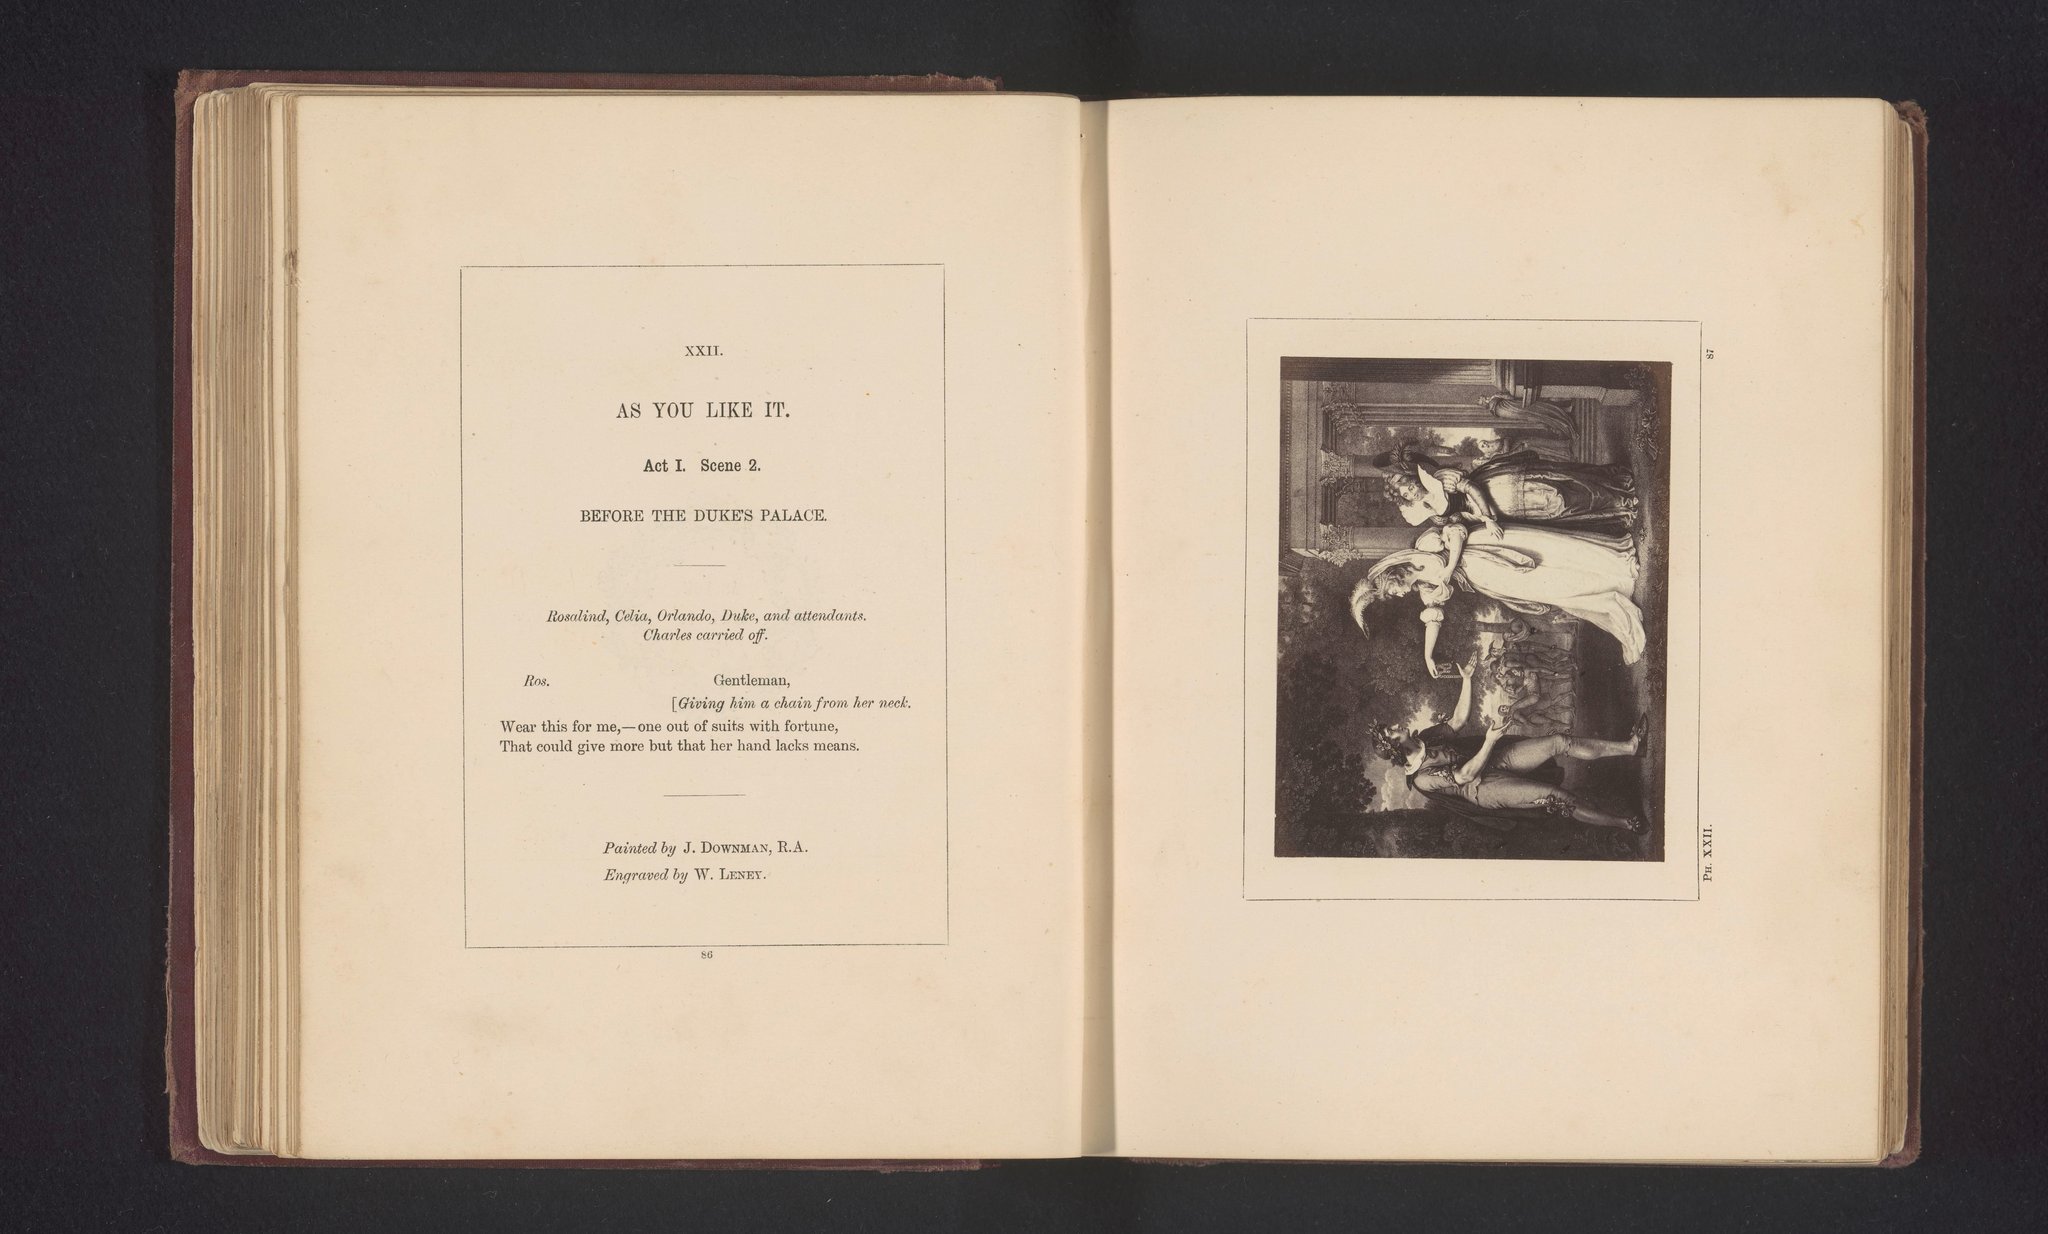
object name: photograph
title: Fotoreproductie van een prent naar een schilderij door John Downman, voorstellend een scene uit Naar het u bevalt door William Shakespeare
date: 1854-1867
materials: photographic support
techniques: albumen print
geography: london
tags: specific works of literature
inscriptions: number: ‘Ph. XXII. 87’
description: Te zien is akte I, scene 2 met Rosalind, Celia en Orlando voor het paleis van de hertog.